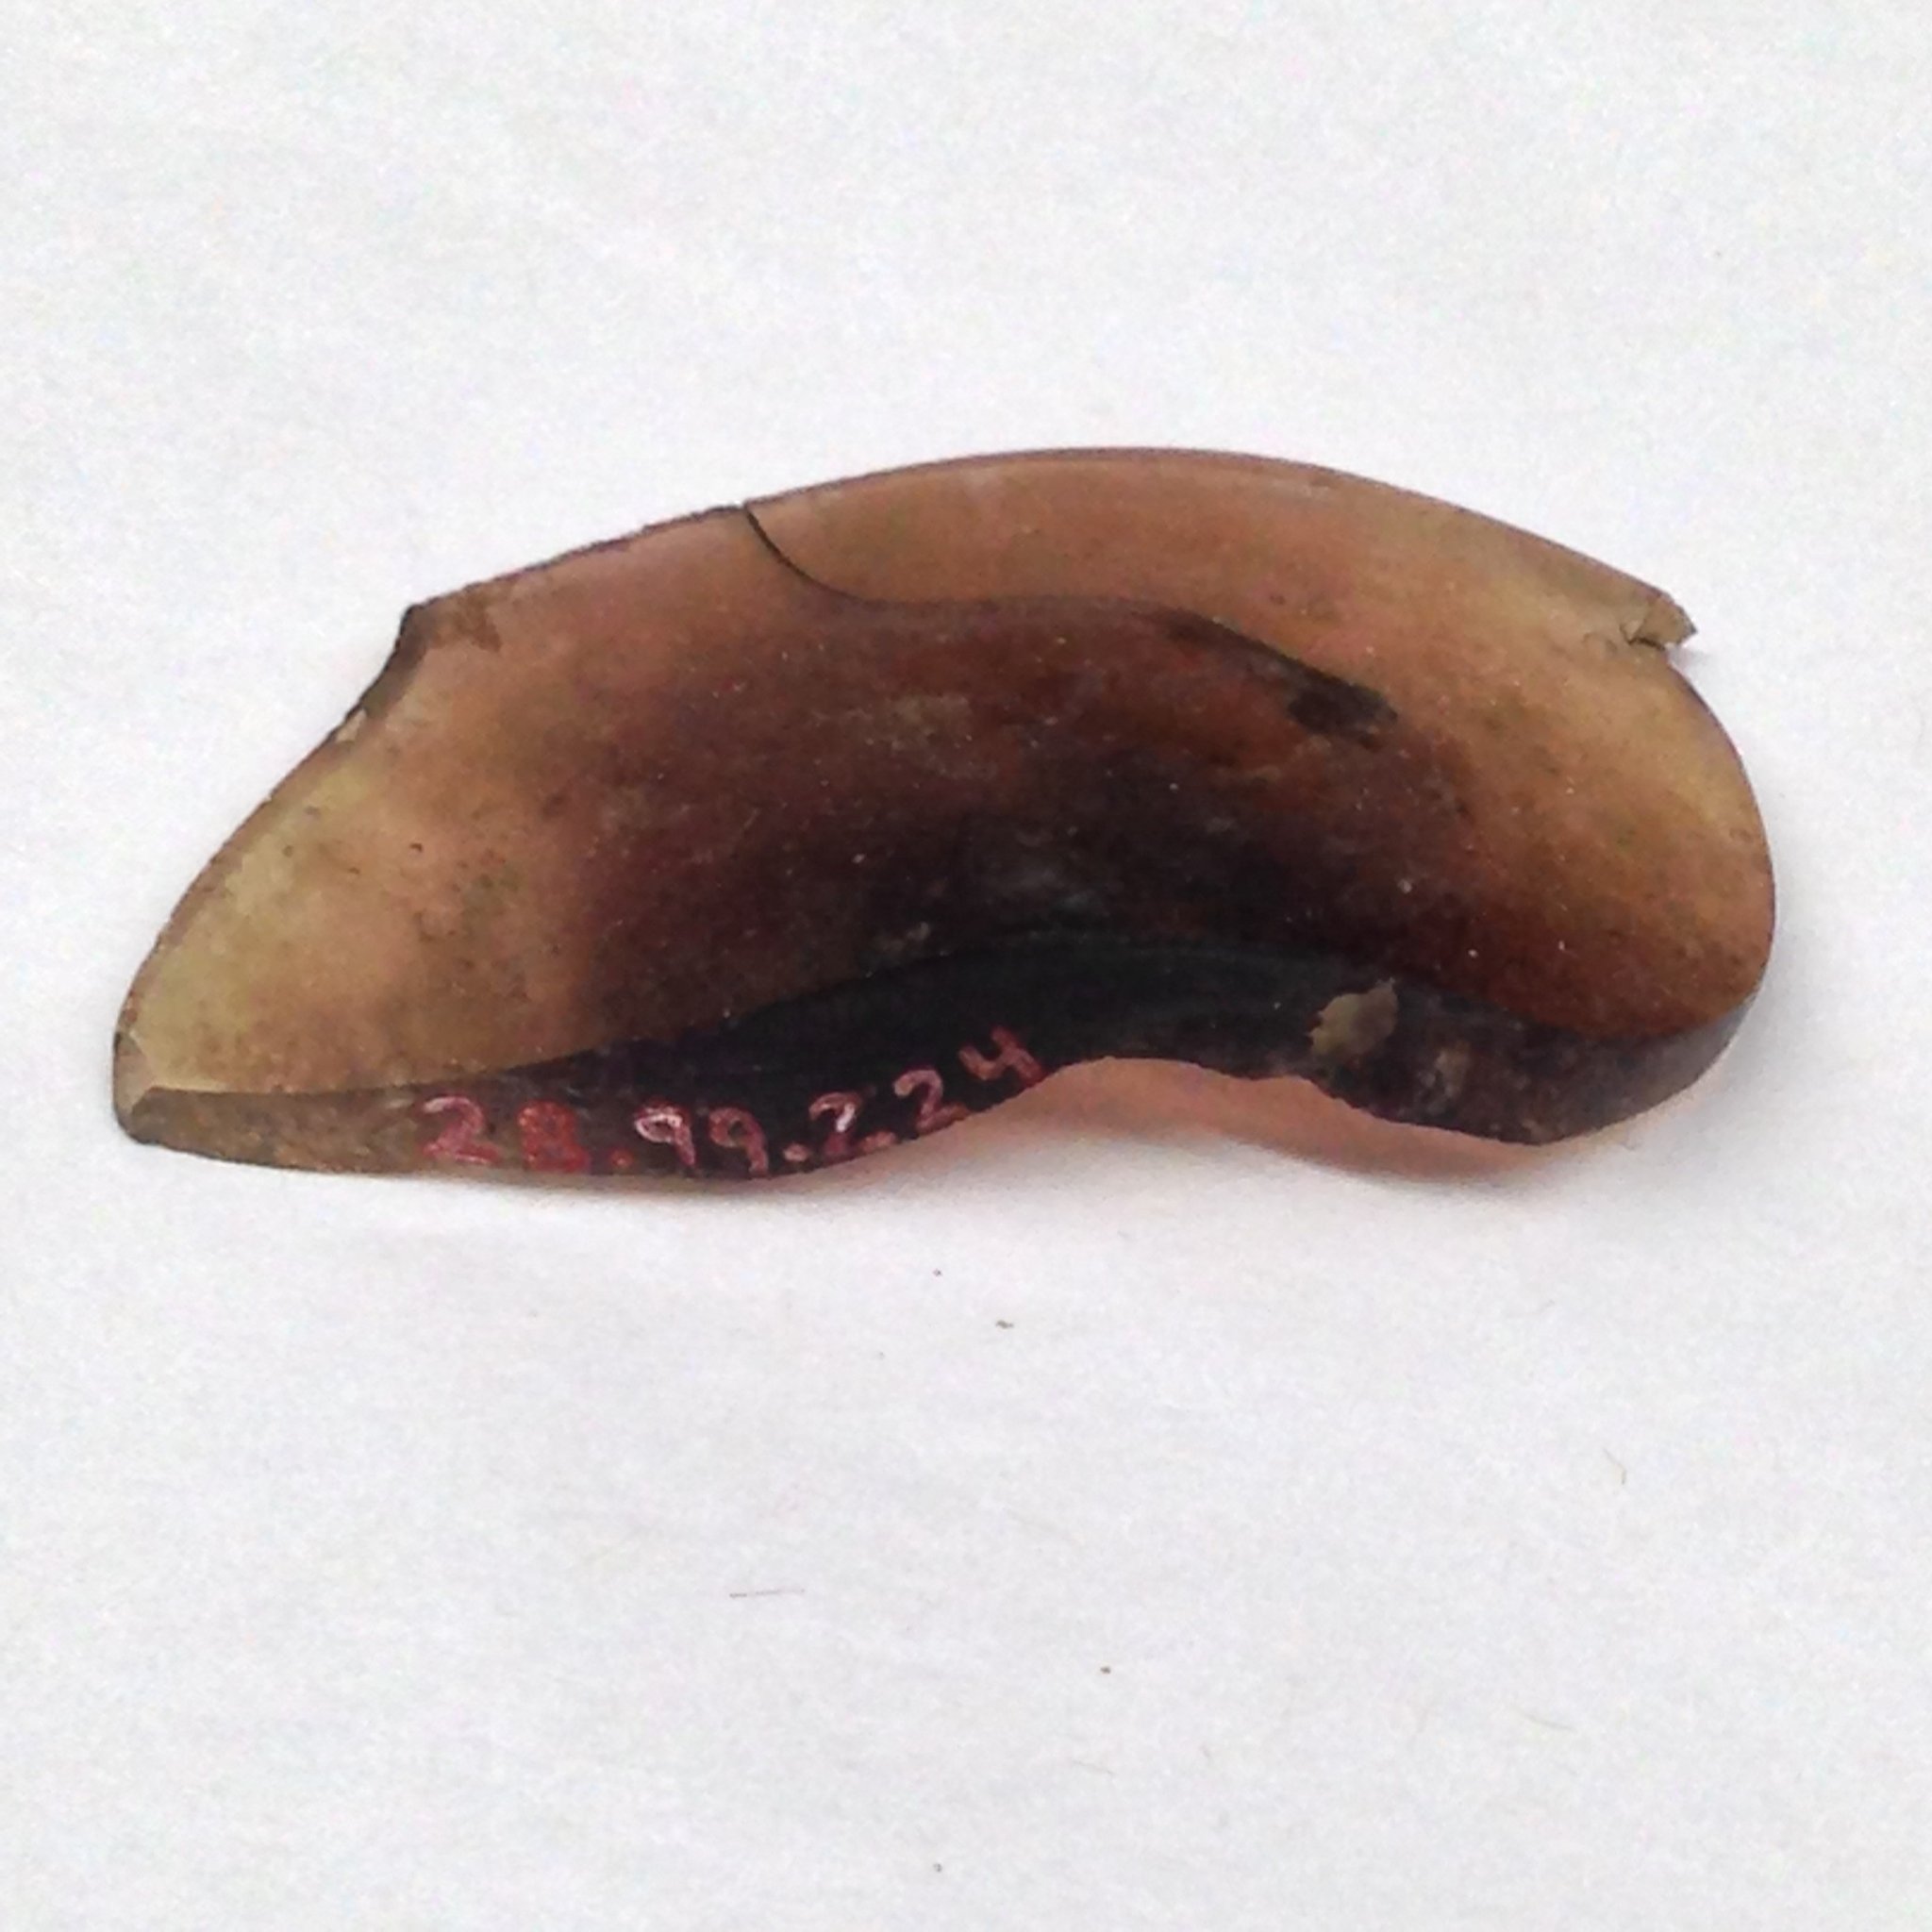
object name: fragment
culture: european or middle eastern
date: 1150-1250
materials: ceramic, glass